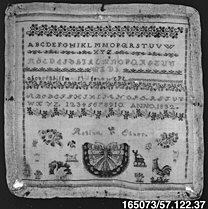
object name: sampler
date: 1832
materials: silk, wool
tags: birds,roosters